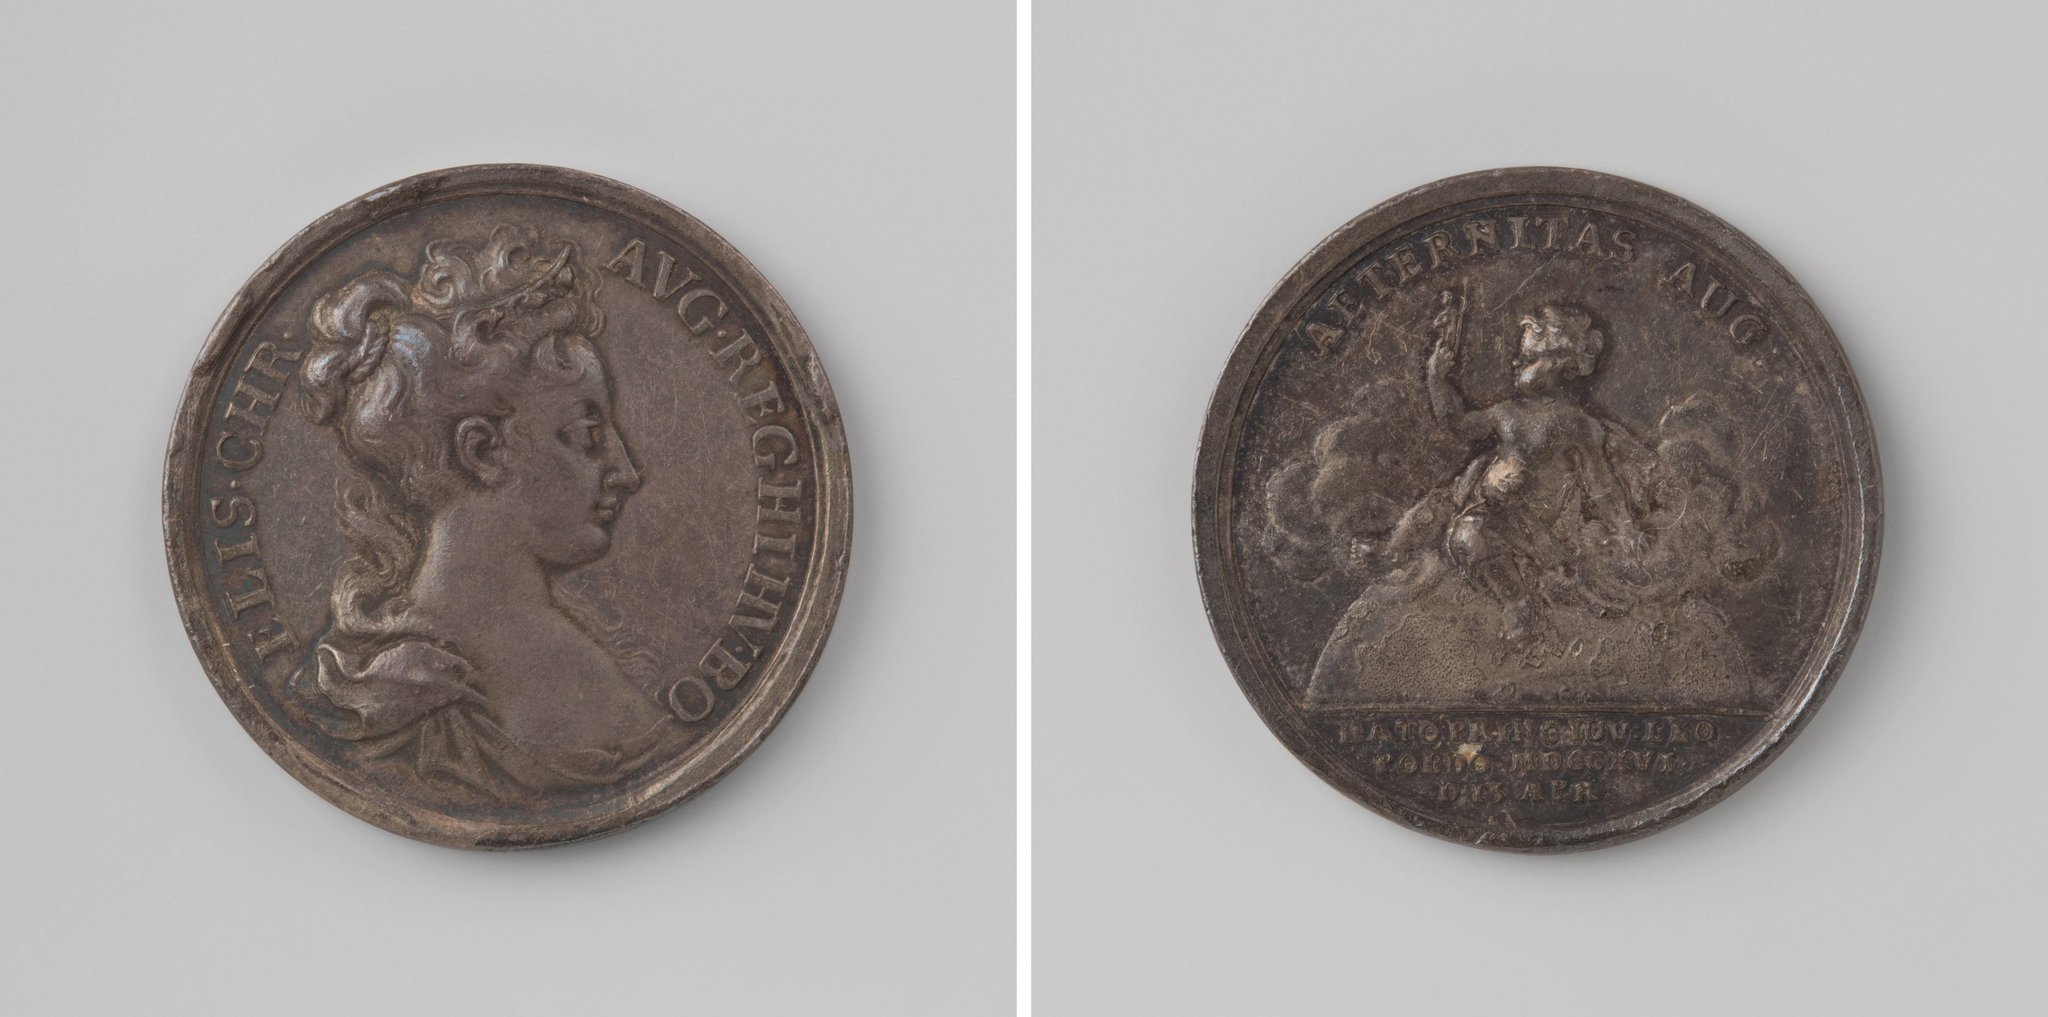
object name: jeton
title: Geboorte van prins Leopold van Oostenrijk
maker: philippe roëttiers (ii)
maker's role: medailleur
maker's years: 1640-1718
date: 1716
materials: silver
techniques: striking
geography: antwerp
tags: keizerin, elisabeth christina (keizerin van oostenrijk), aartshertog van oostenrijk leopold johann josef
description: Zilveren penning. Voorzijde: borststuk vrouw binnen omschrift. Keerzijde: kind zittend op wereldbol, omringd door wolken, houdt in hand beeld van Rome binnen omschrift; afsnede: opschrift